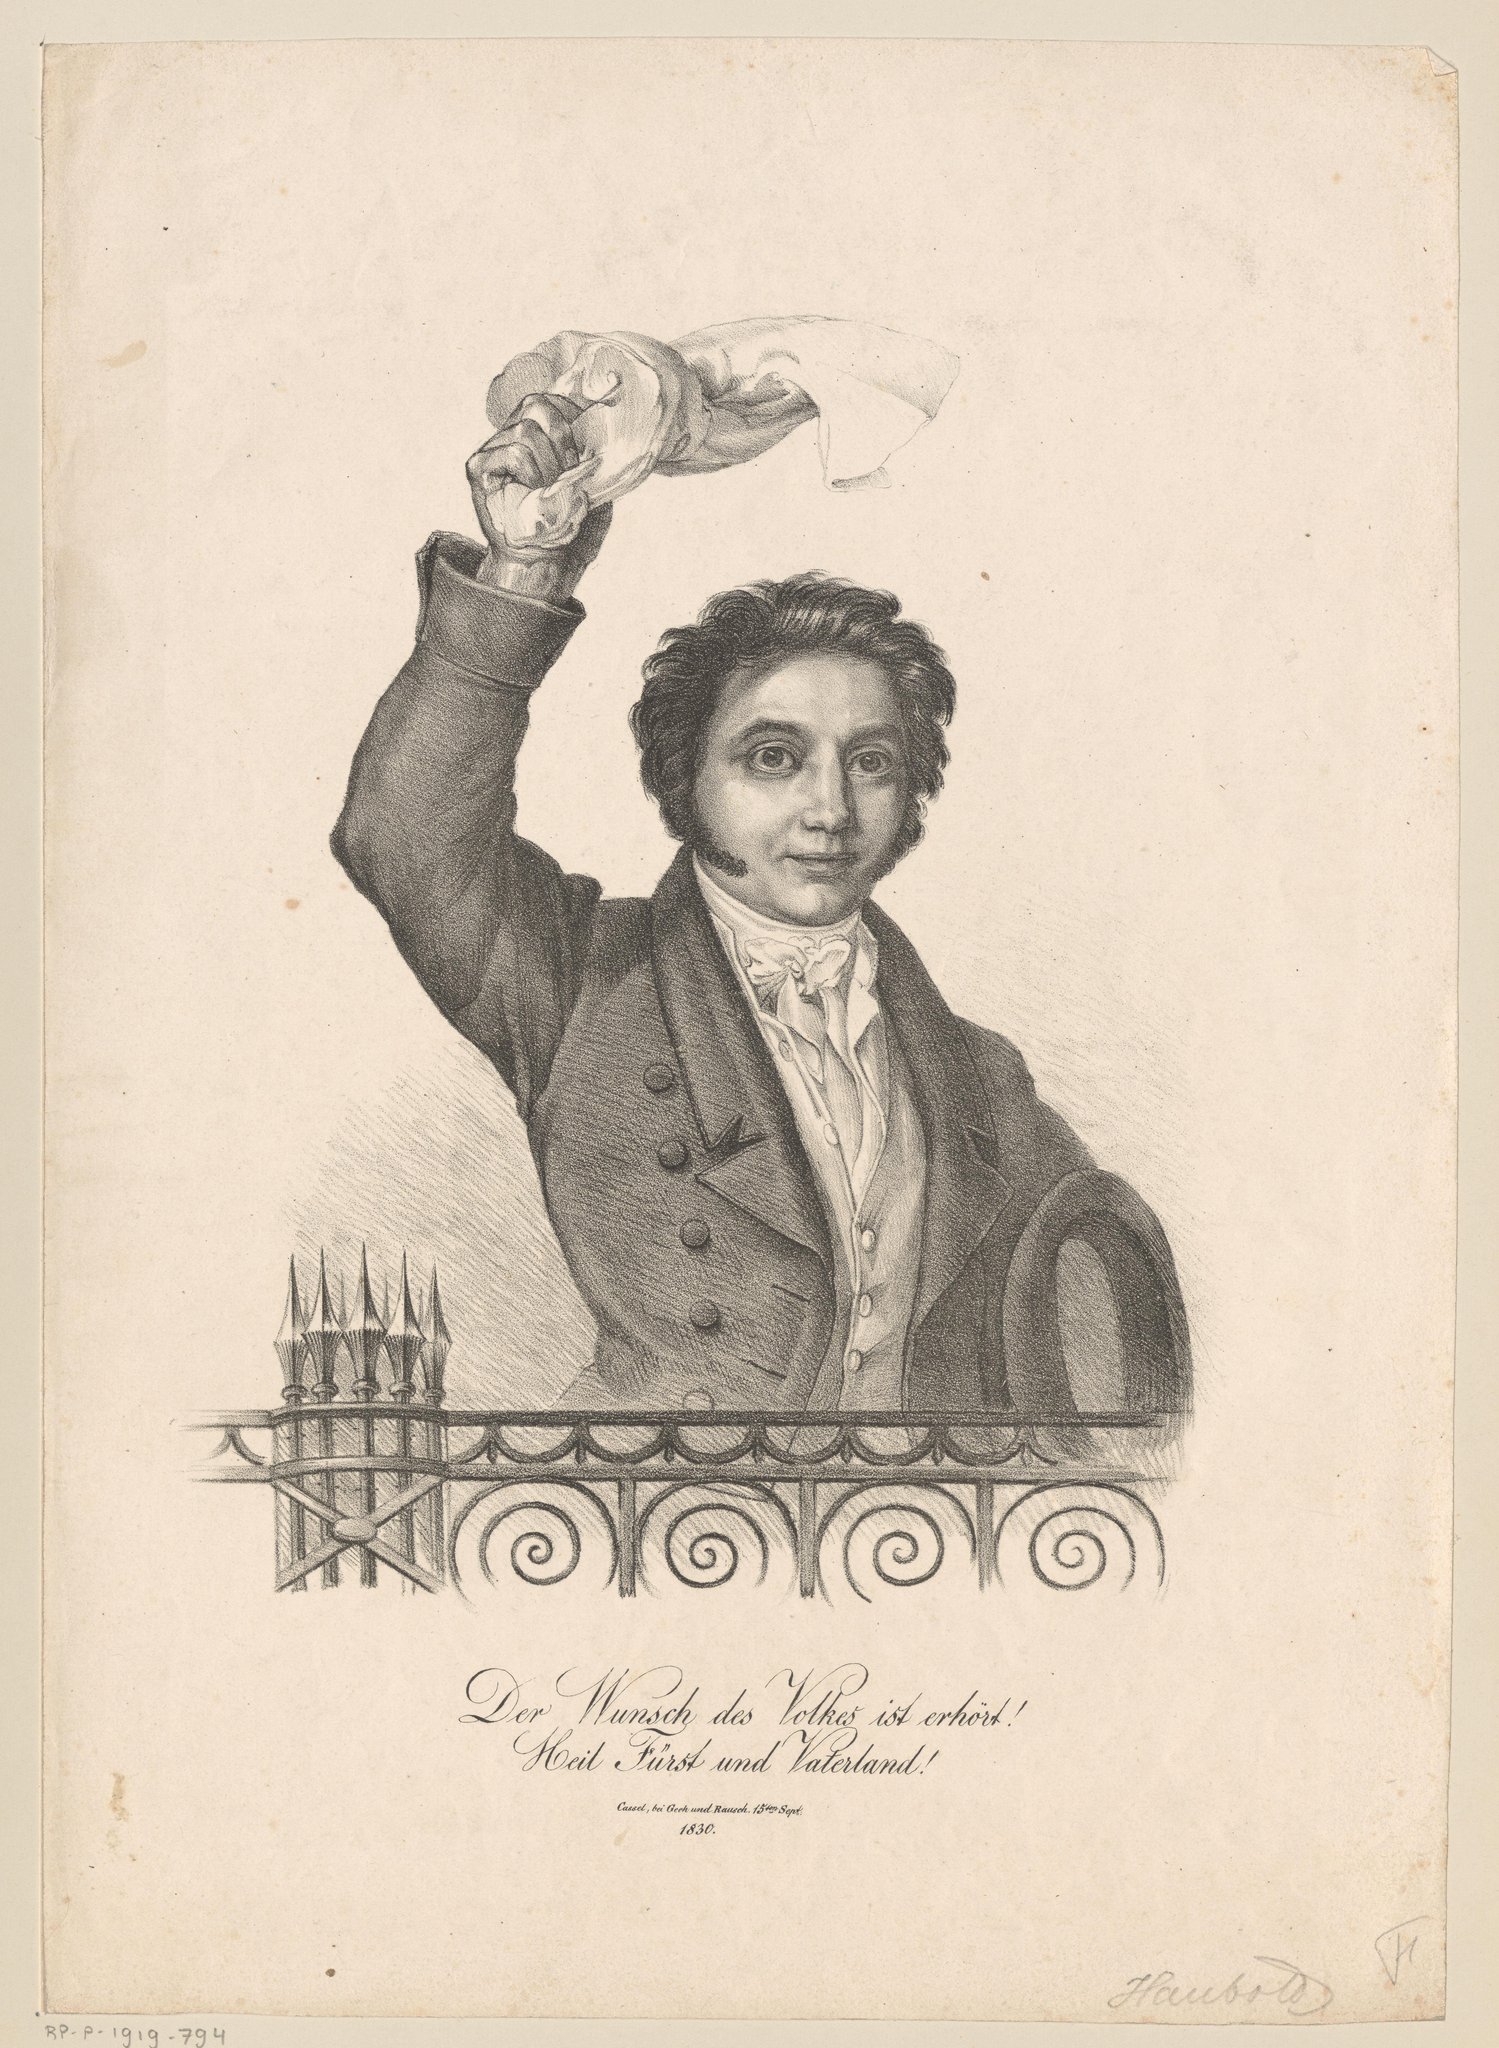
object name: print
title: Der Wunsch des Volkes ist erhört! Heil Fürst und Vaterland!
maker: Anonymous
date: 1830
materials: paper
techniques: lithograph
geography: kassel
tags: manufacturer, historical persons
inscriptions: collector's mark: Lugt 2228